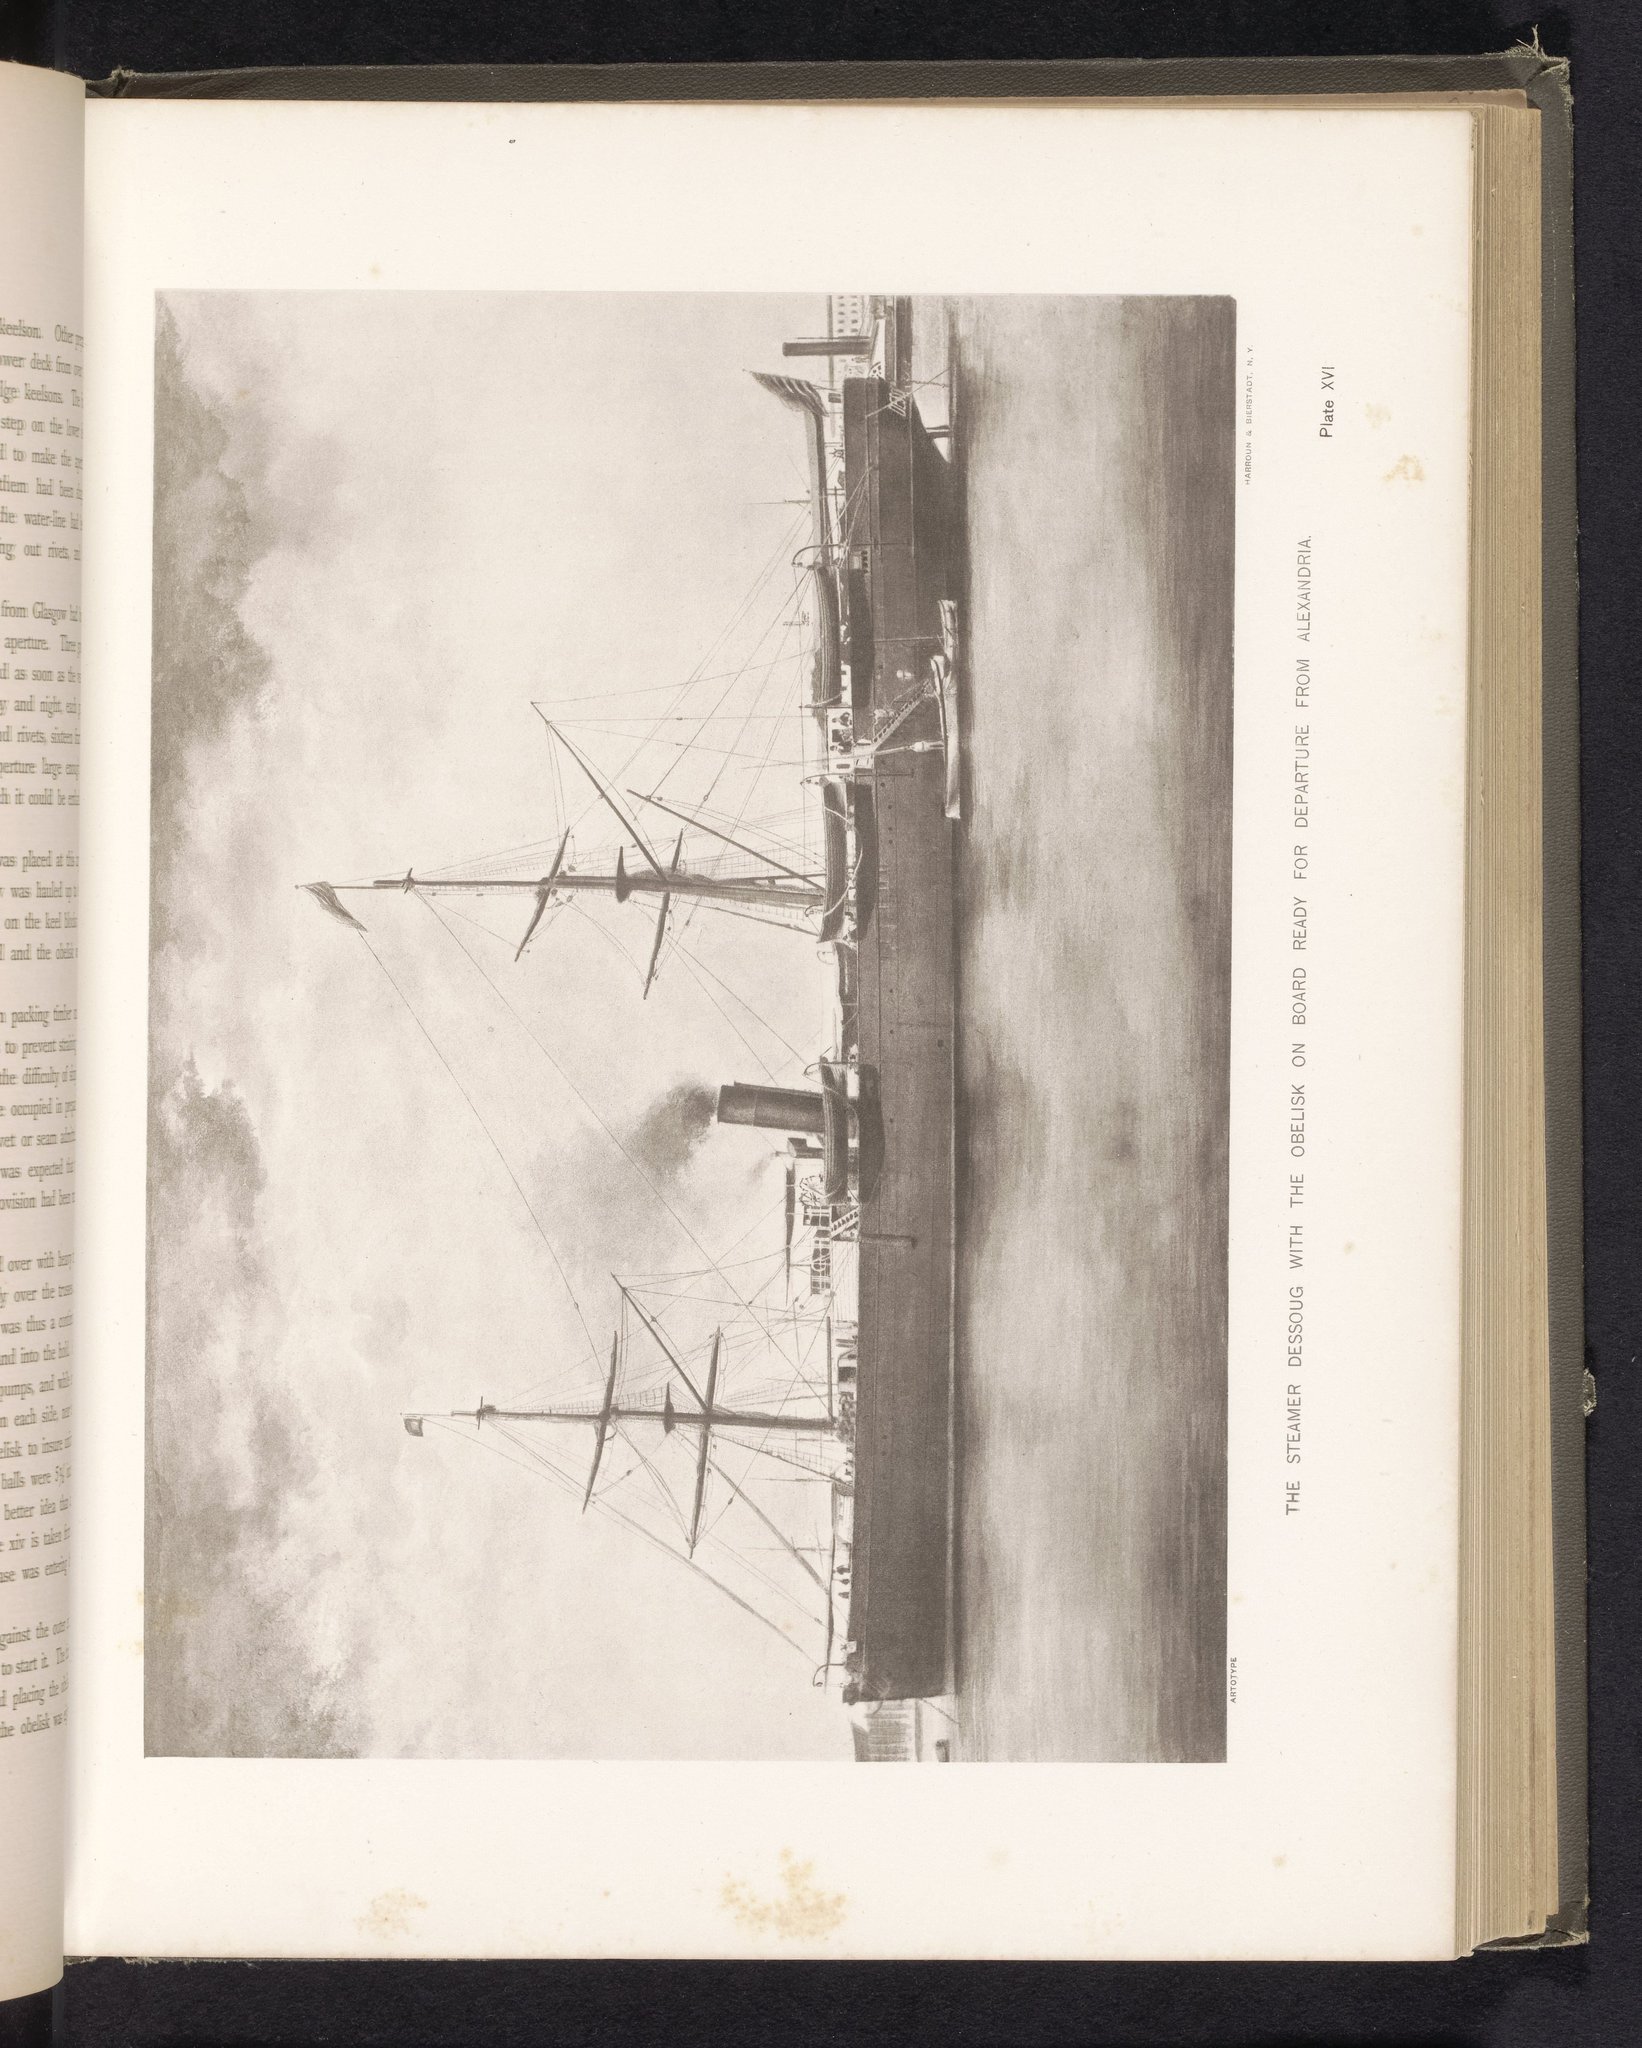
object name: photomechanical print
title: The steamer Dessoug with the obelisk on board ready for departure from Alexandria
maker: Anonymous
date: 1880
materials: paper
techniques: photograph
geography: new york city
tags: obelisk, needle, steamship, motorship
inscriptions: number: ‘Plate XVI’